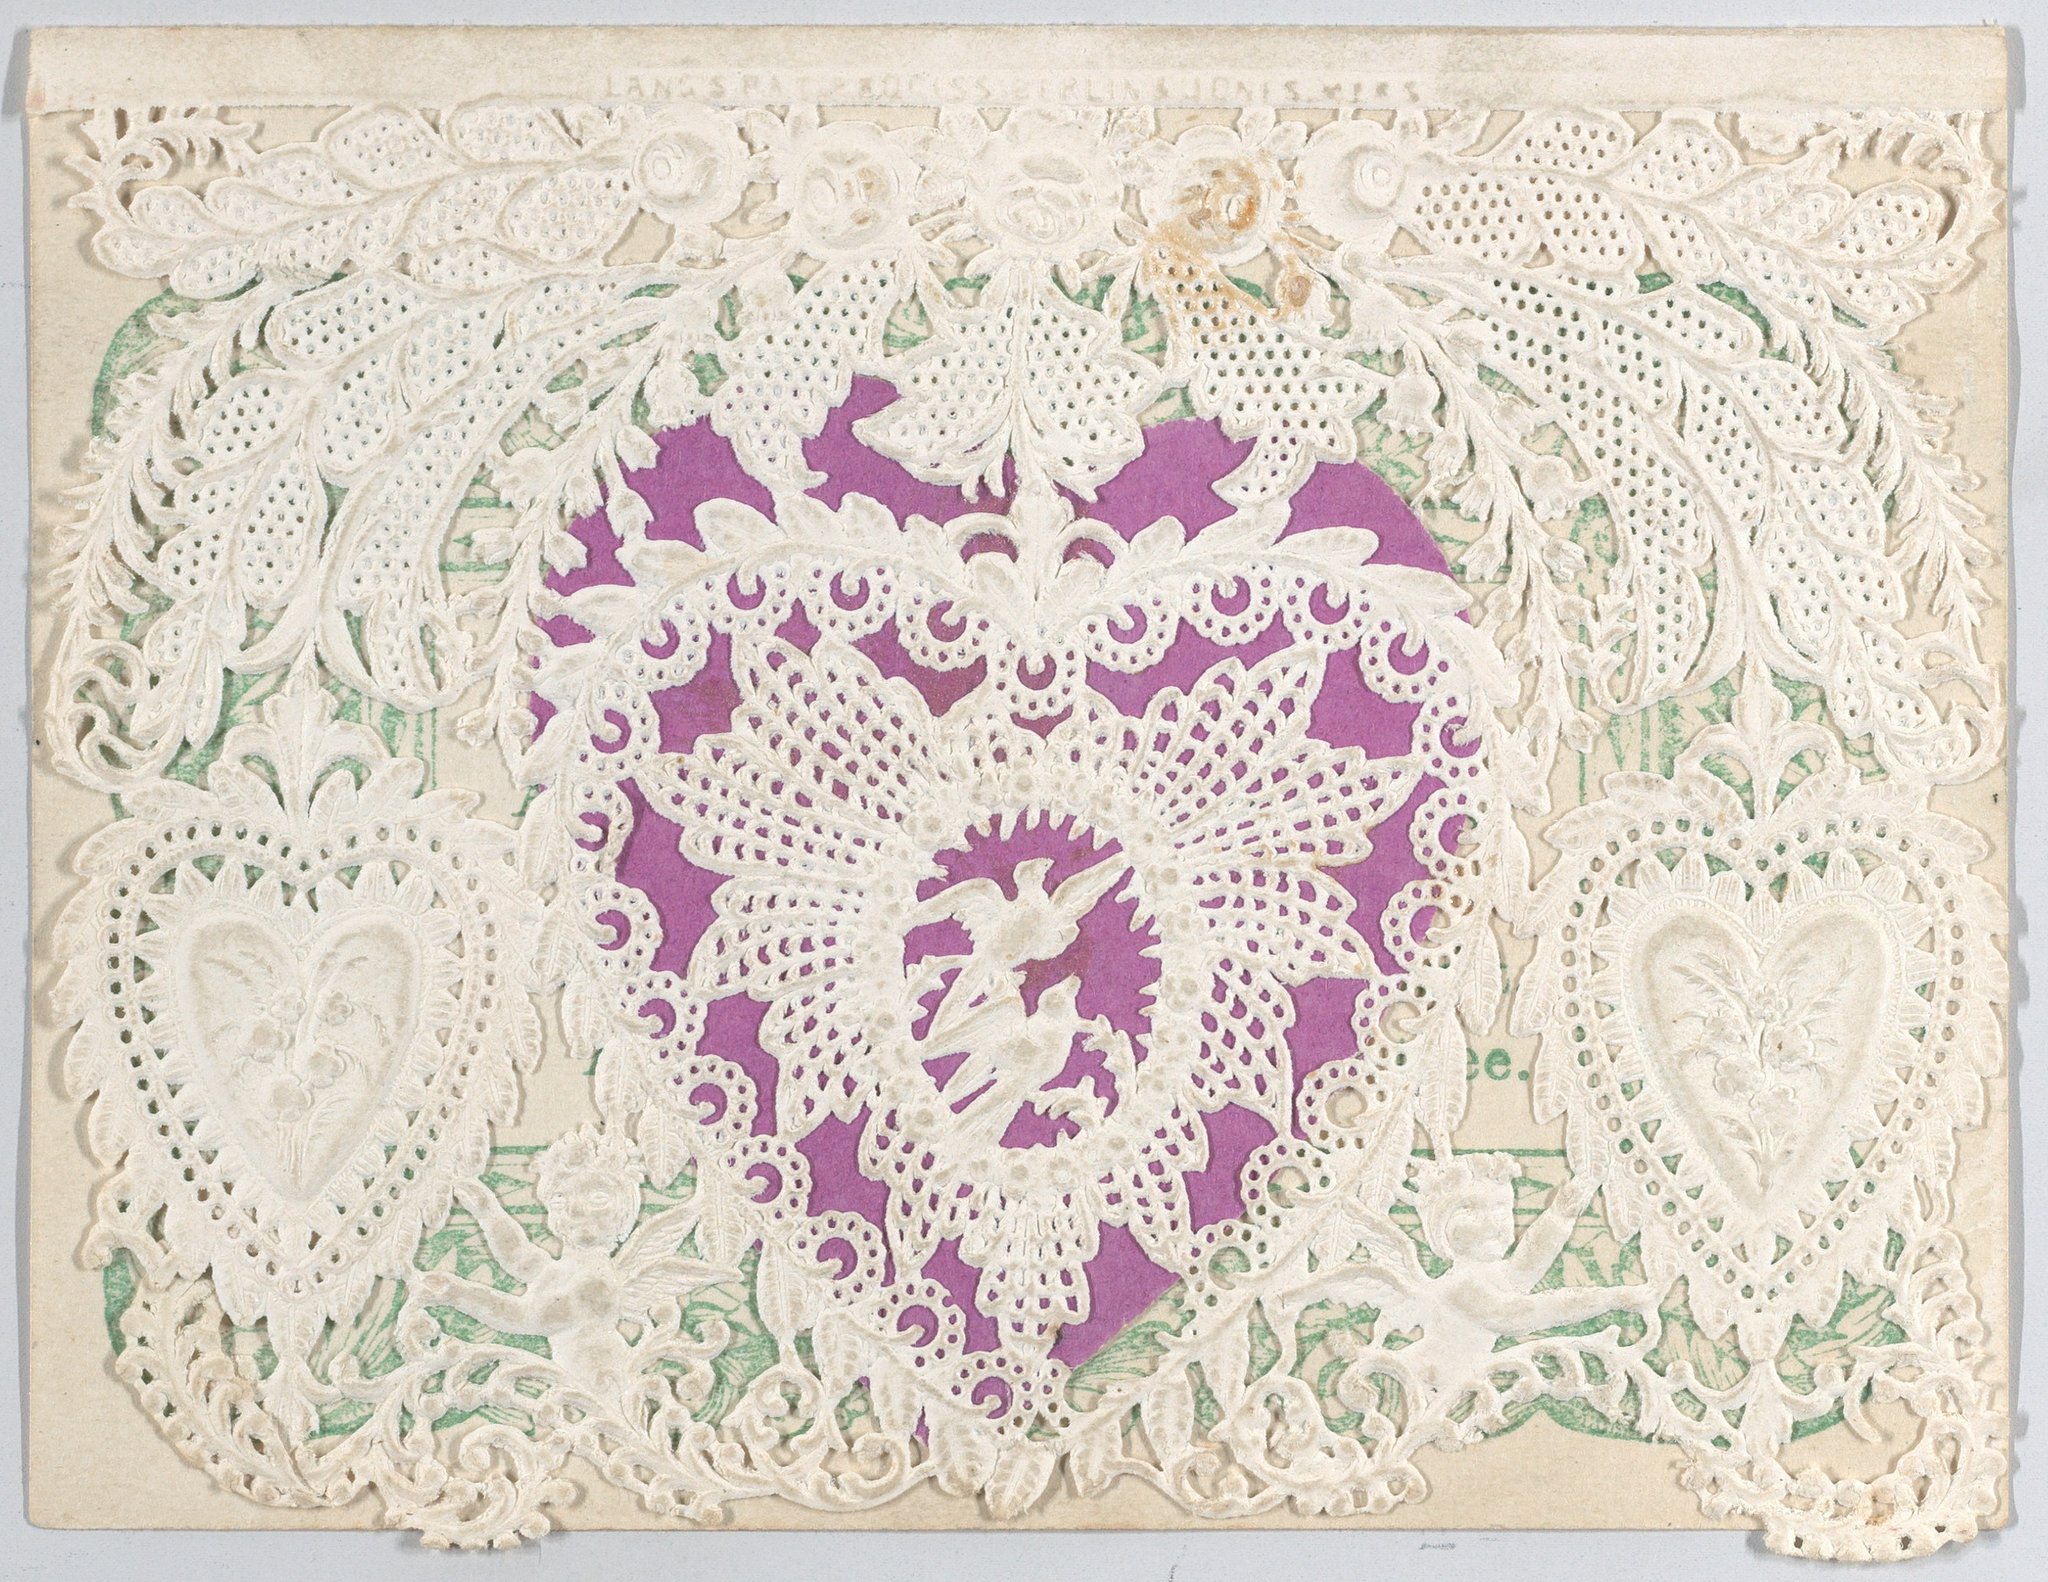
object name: valentine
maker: Anonymous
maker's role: artist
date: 1850-1870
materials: ink, lace, paper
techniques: embossing, open work